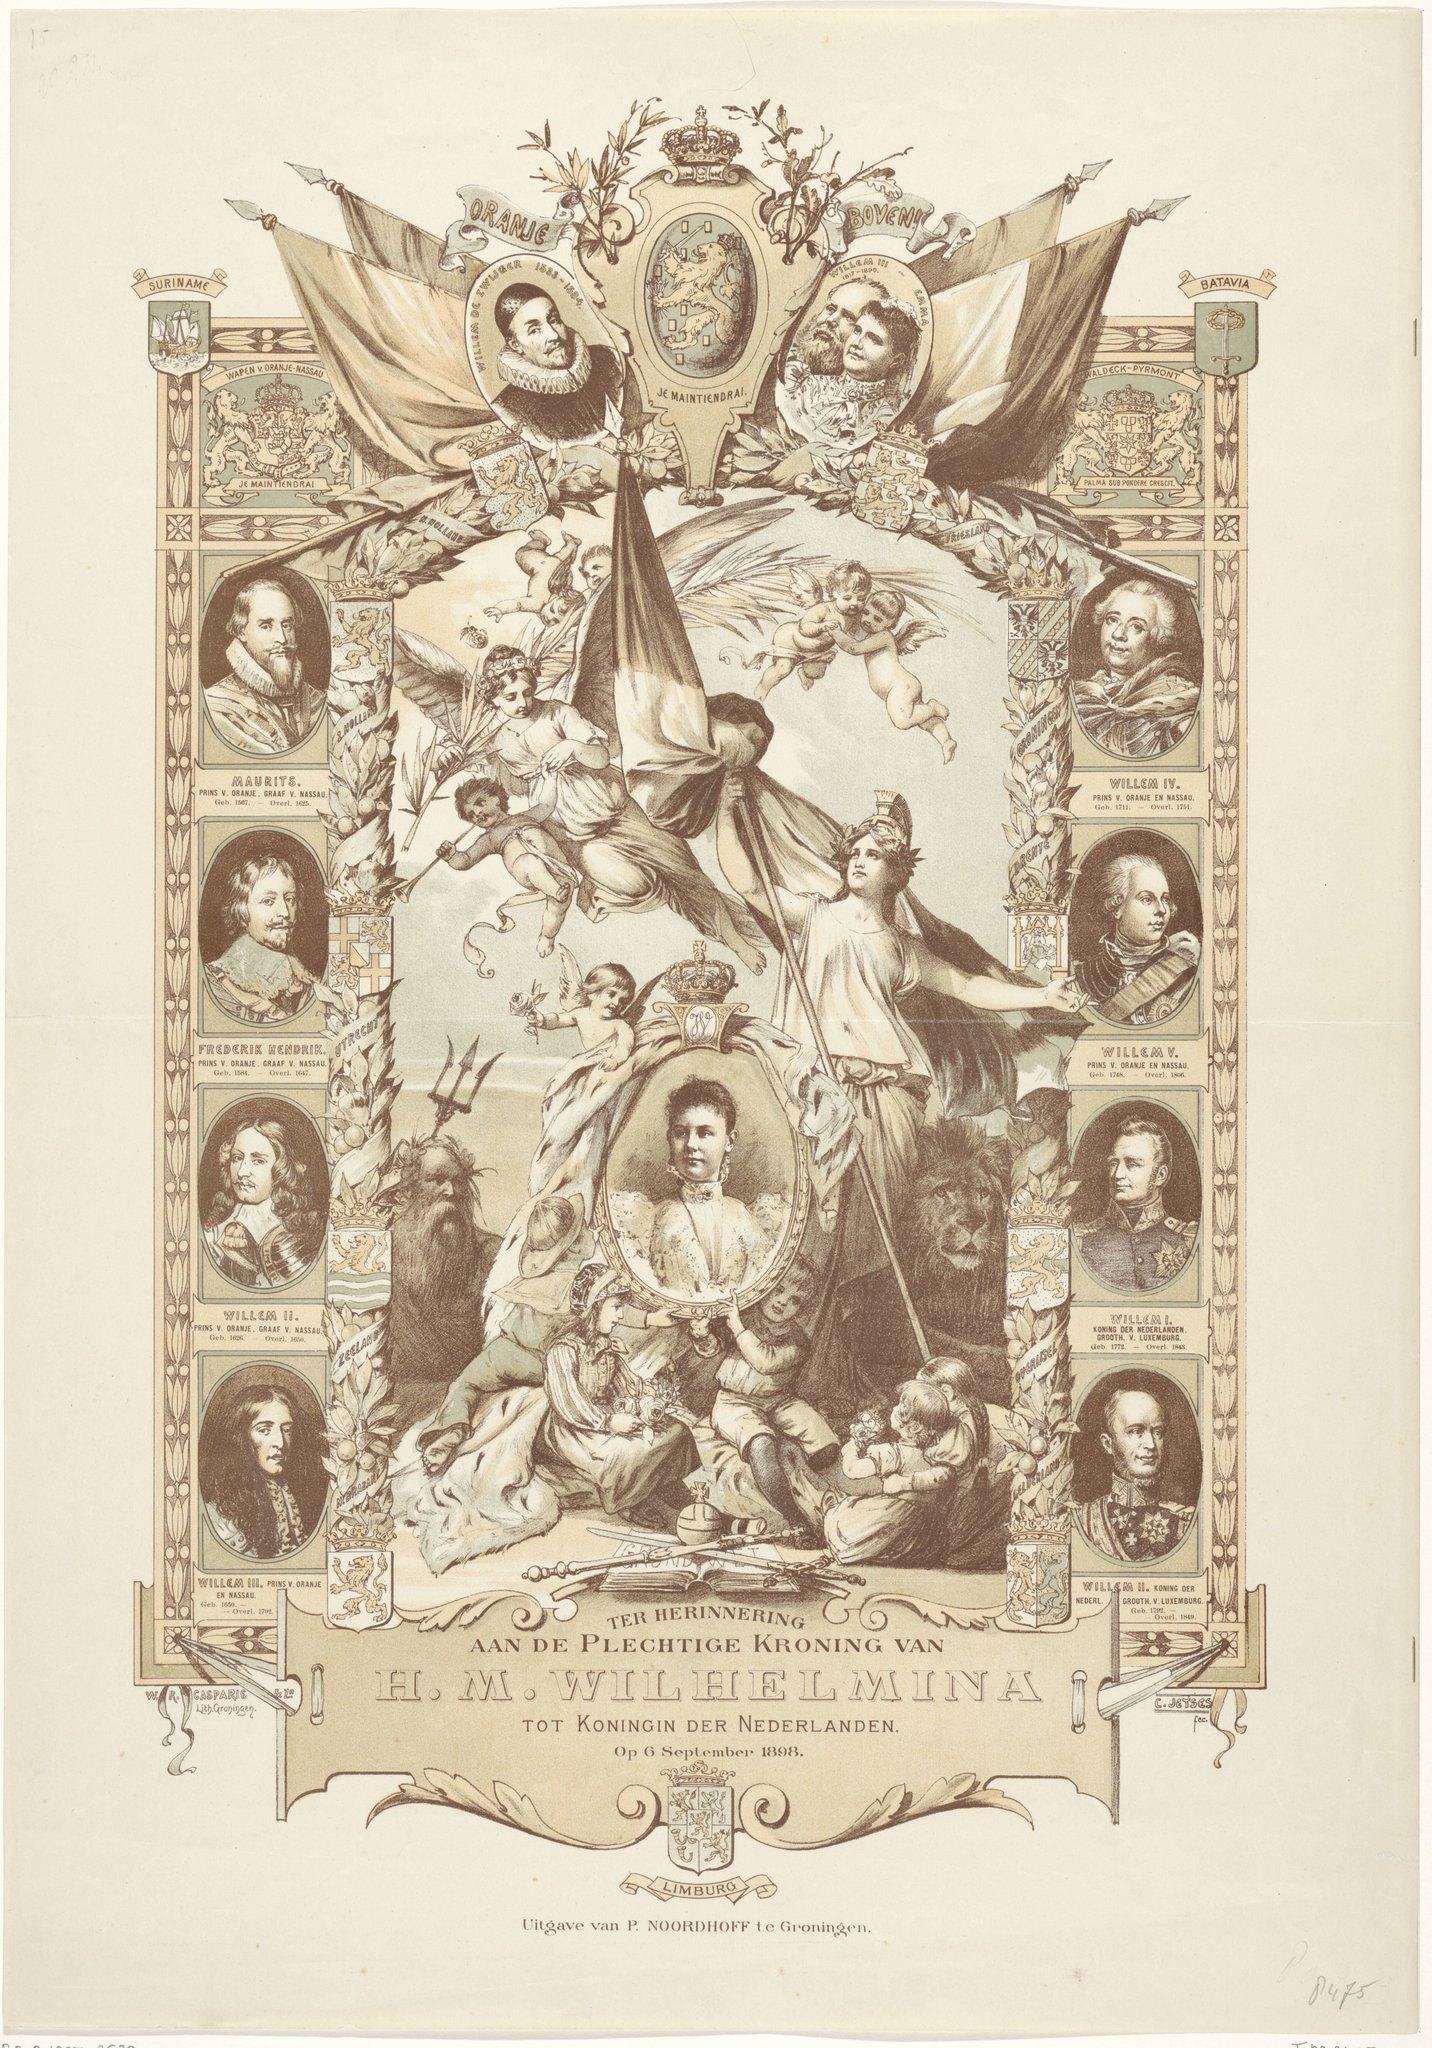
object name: print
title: Ter herinnering aan de Plechtige Kroning van H.M. Koningin Wilhelmina tot Koningin der Nederlanden. Op 6 September 1898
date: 1898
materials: paper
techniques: lithograph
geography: groningen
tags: the hague, print maker, wilhelmina of the netherlands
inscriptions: collector's mark: Lugt 2228, collector's mark: Lugt 2760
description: Gedenkplaat bij de troonsbestijging van koningin Wilhelmina op 6 september 1898. Centraal een portret in medaillon van de koningin omgeven door putti, kinderen en allegorische figuren. Links en rechts portretten van stadhouders en koningen uit het huis Oranje-Nassau.